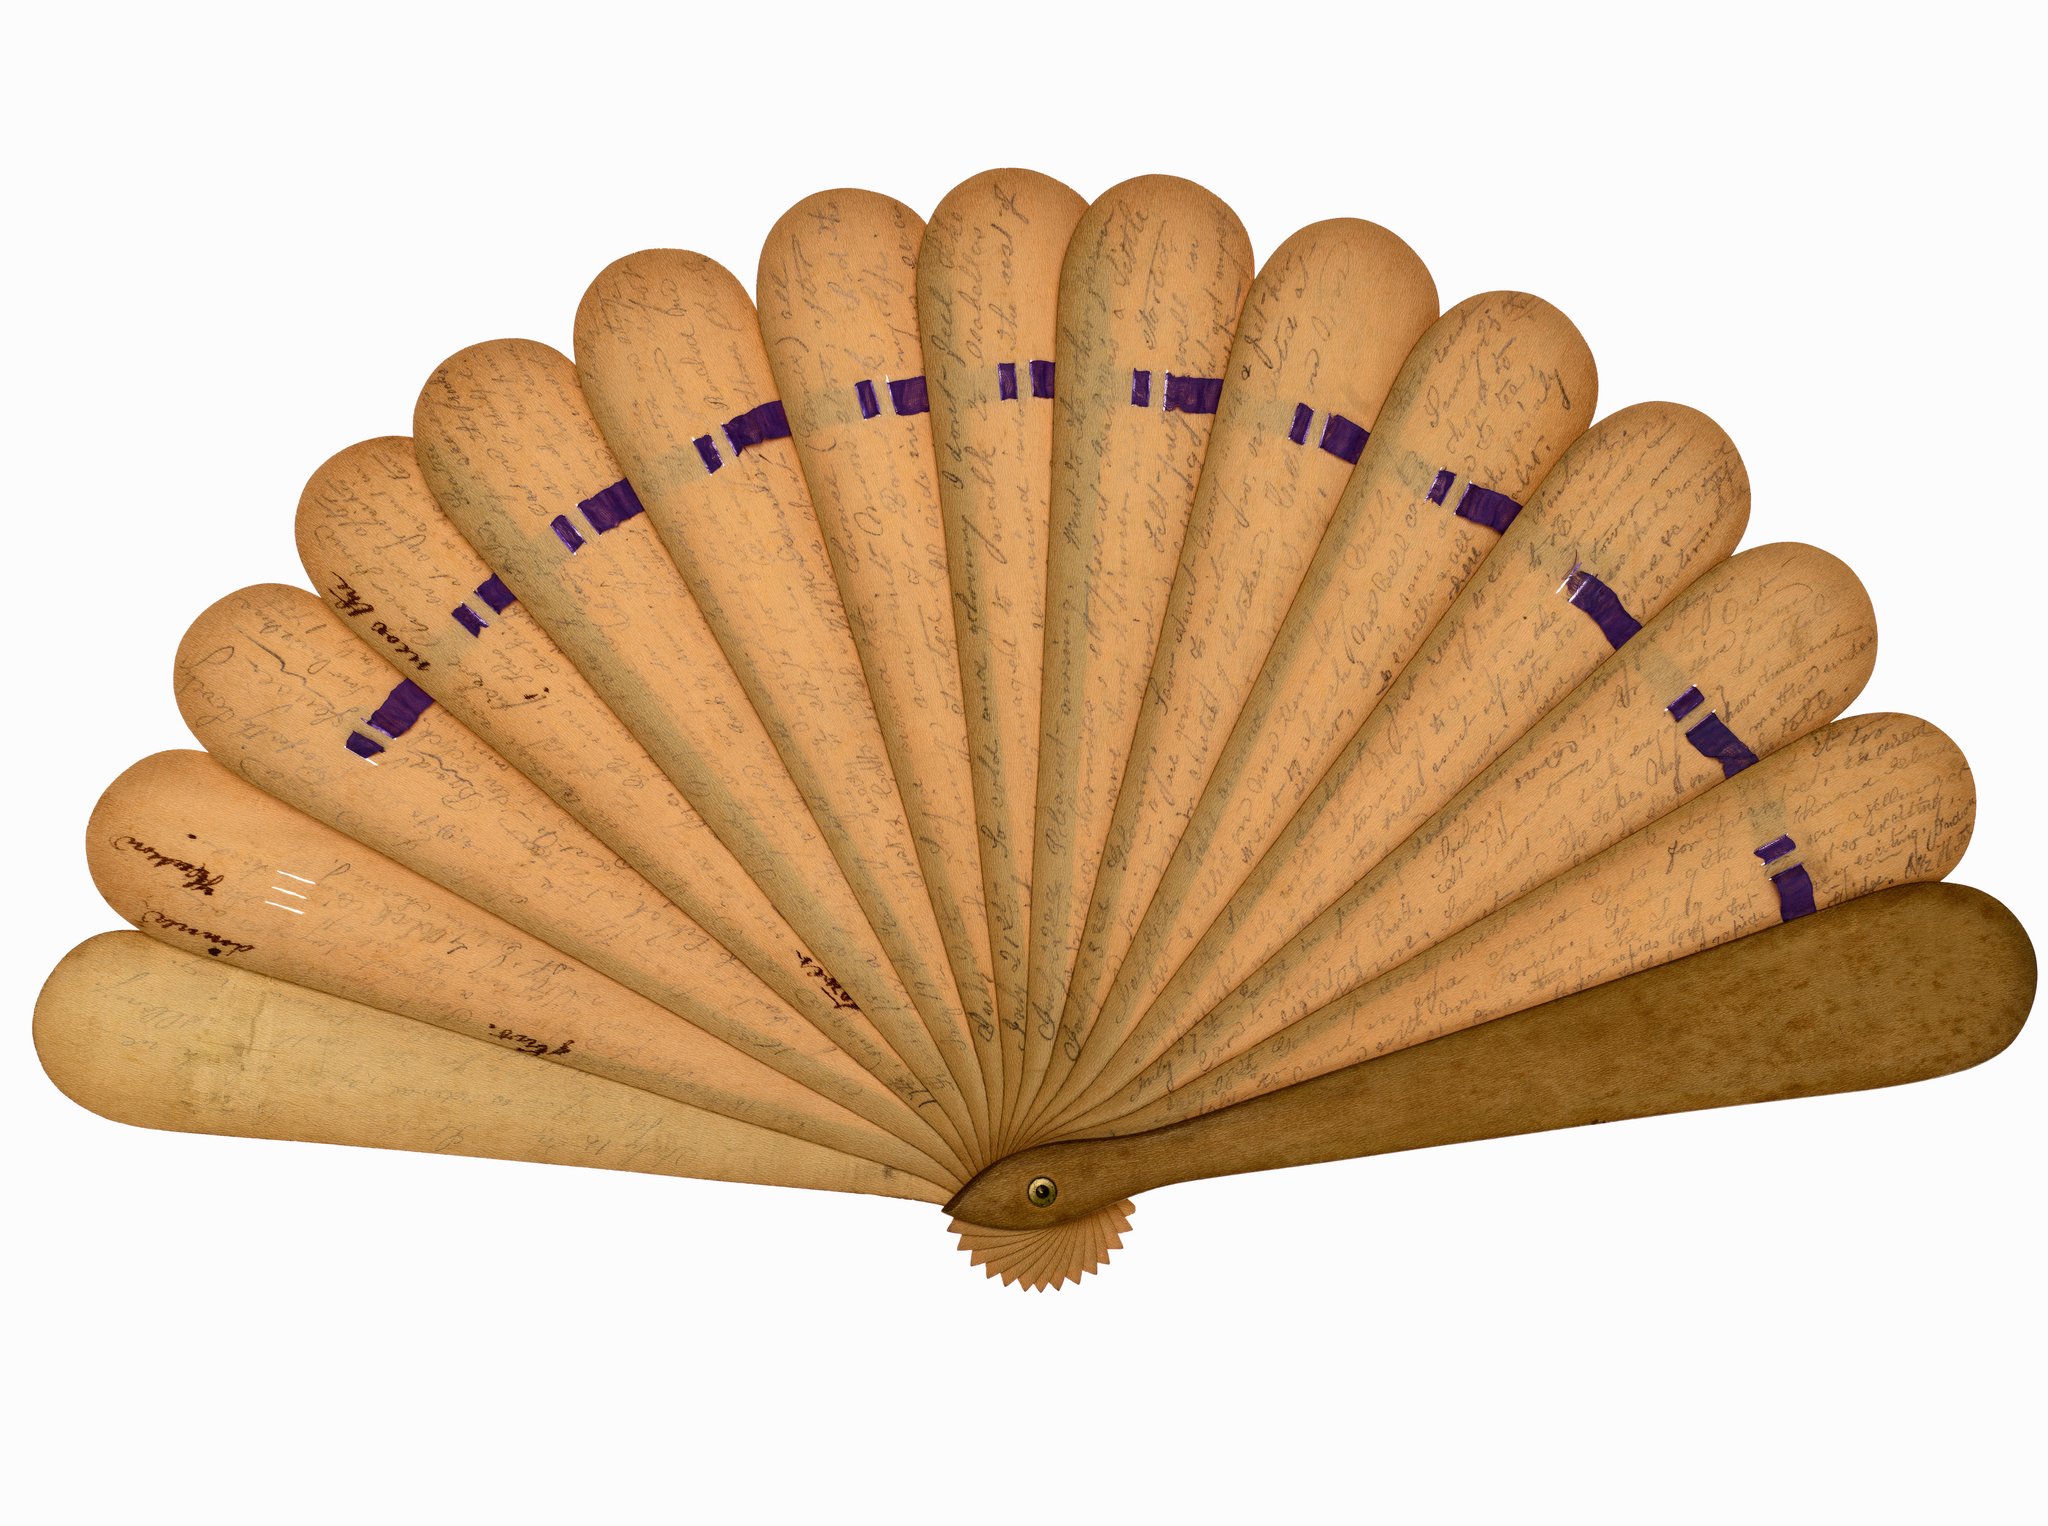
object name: fan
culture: american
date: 1869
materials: wood